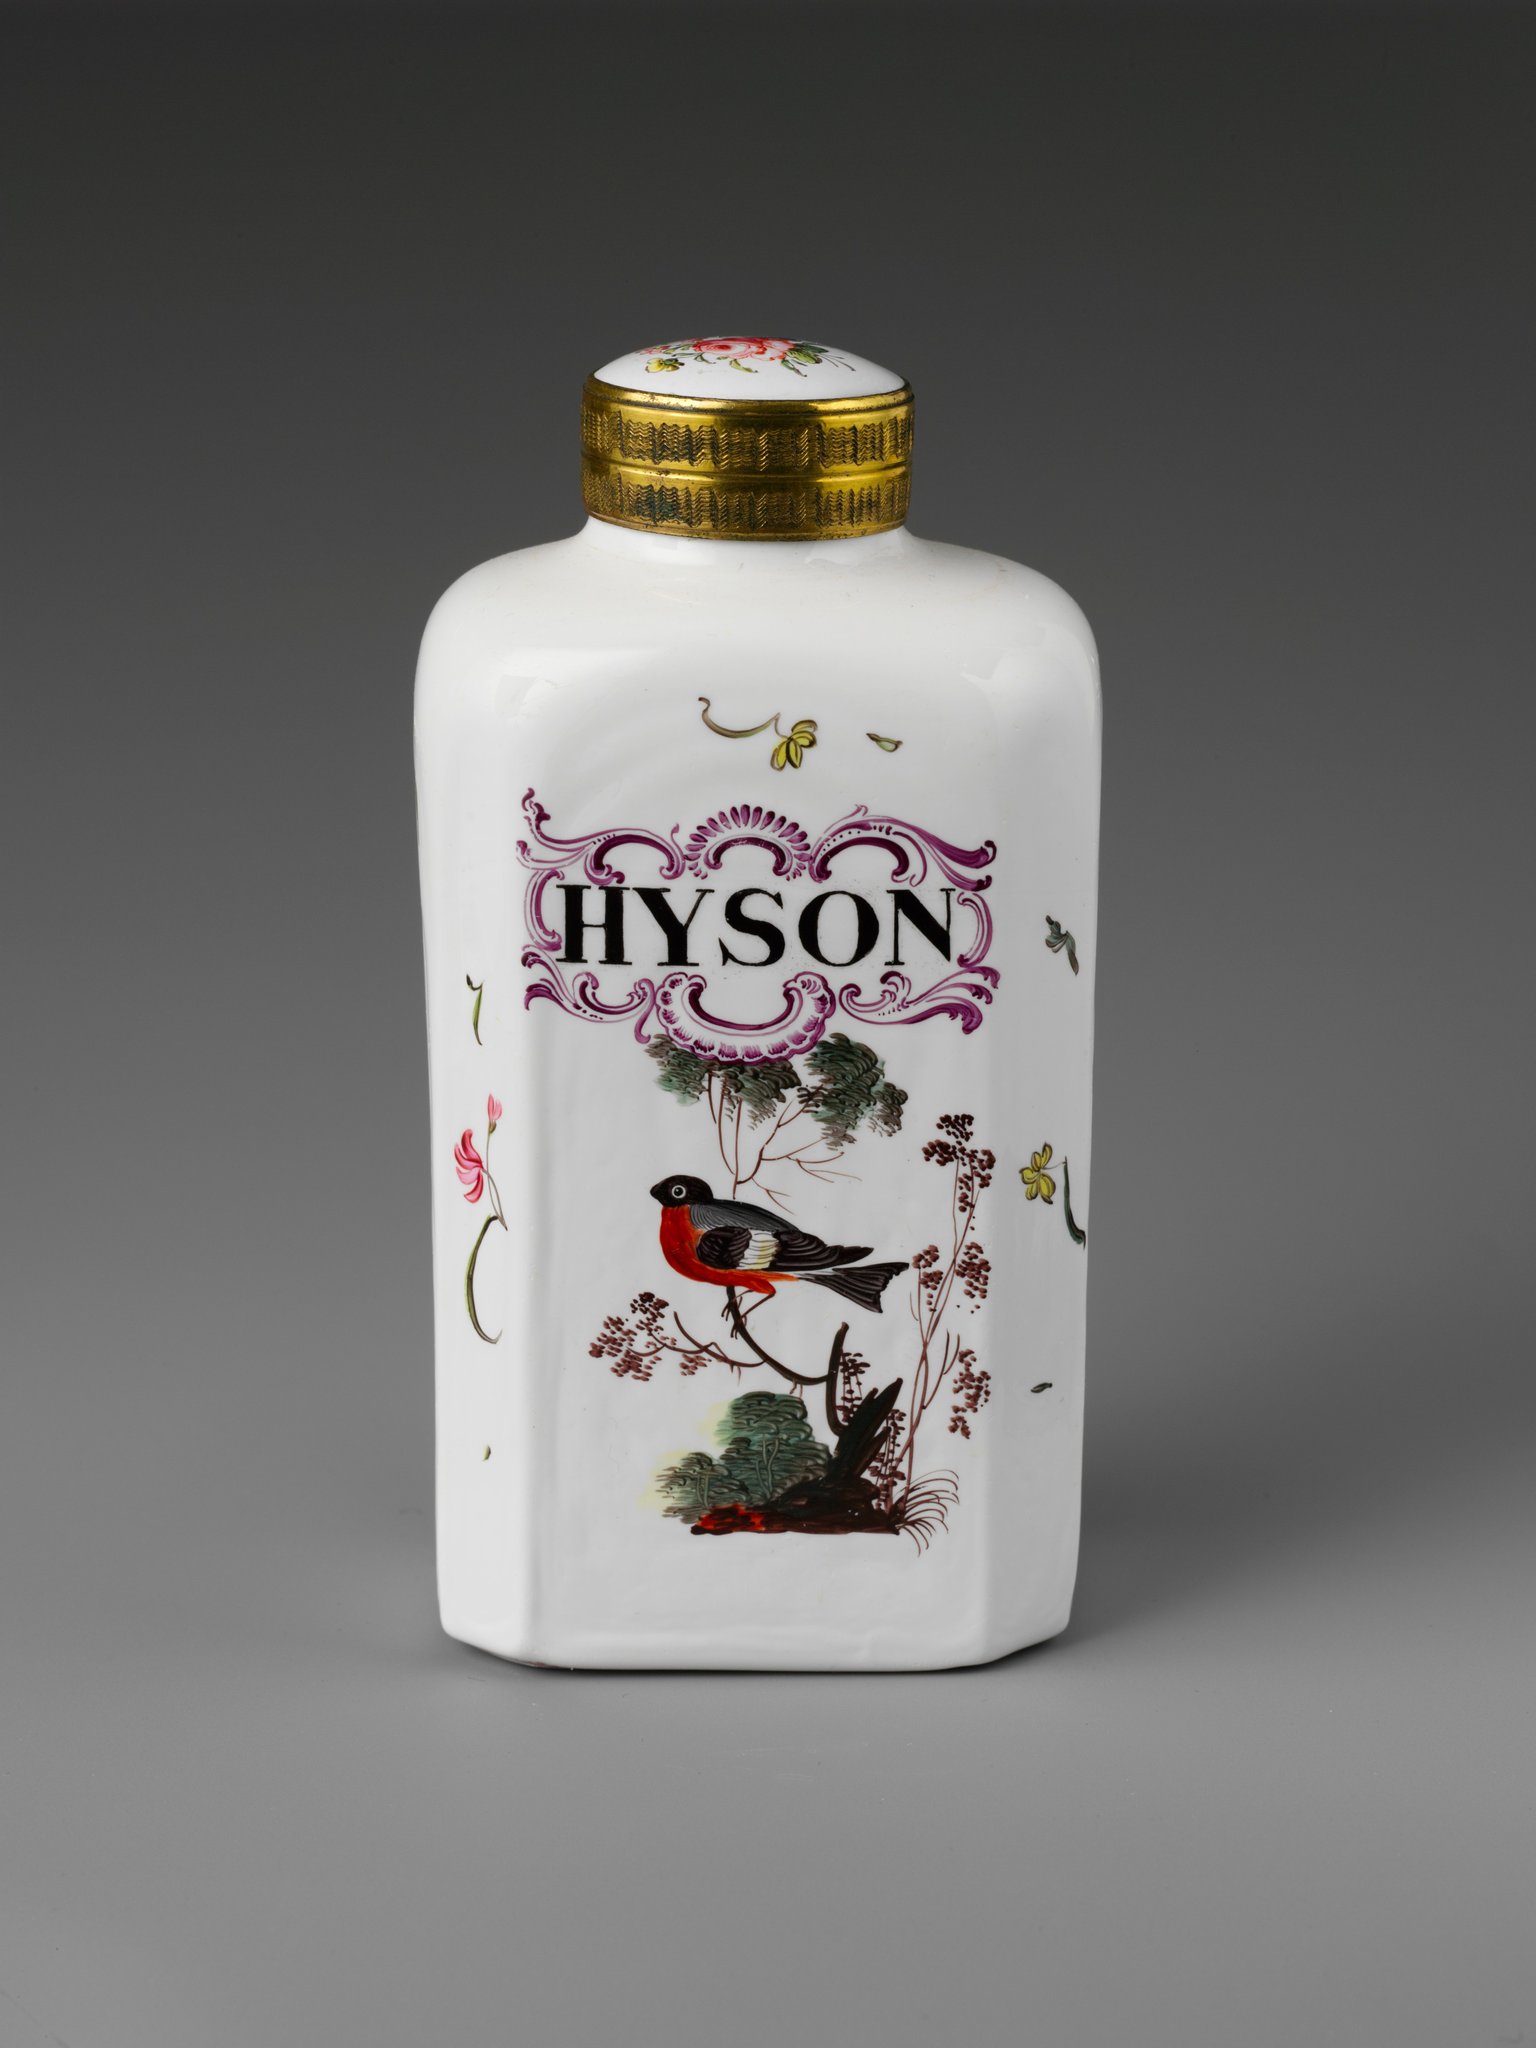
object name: tea caddy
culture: british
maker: michael edkins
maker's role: maker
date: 1760-1770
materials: enamel, glass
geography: england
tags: birds